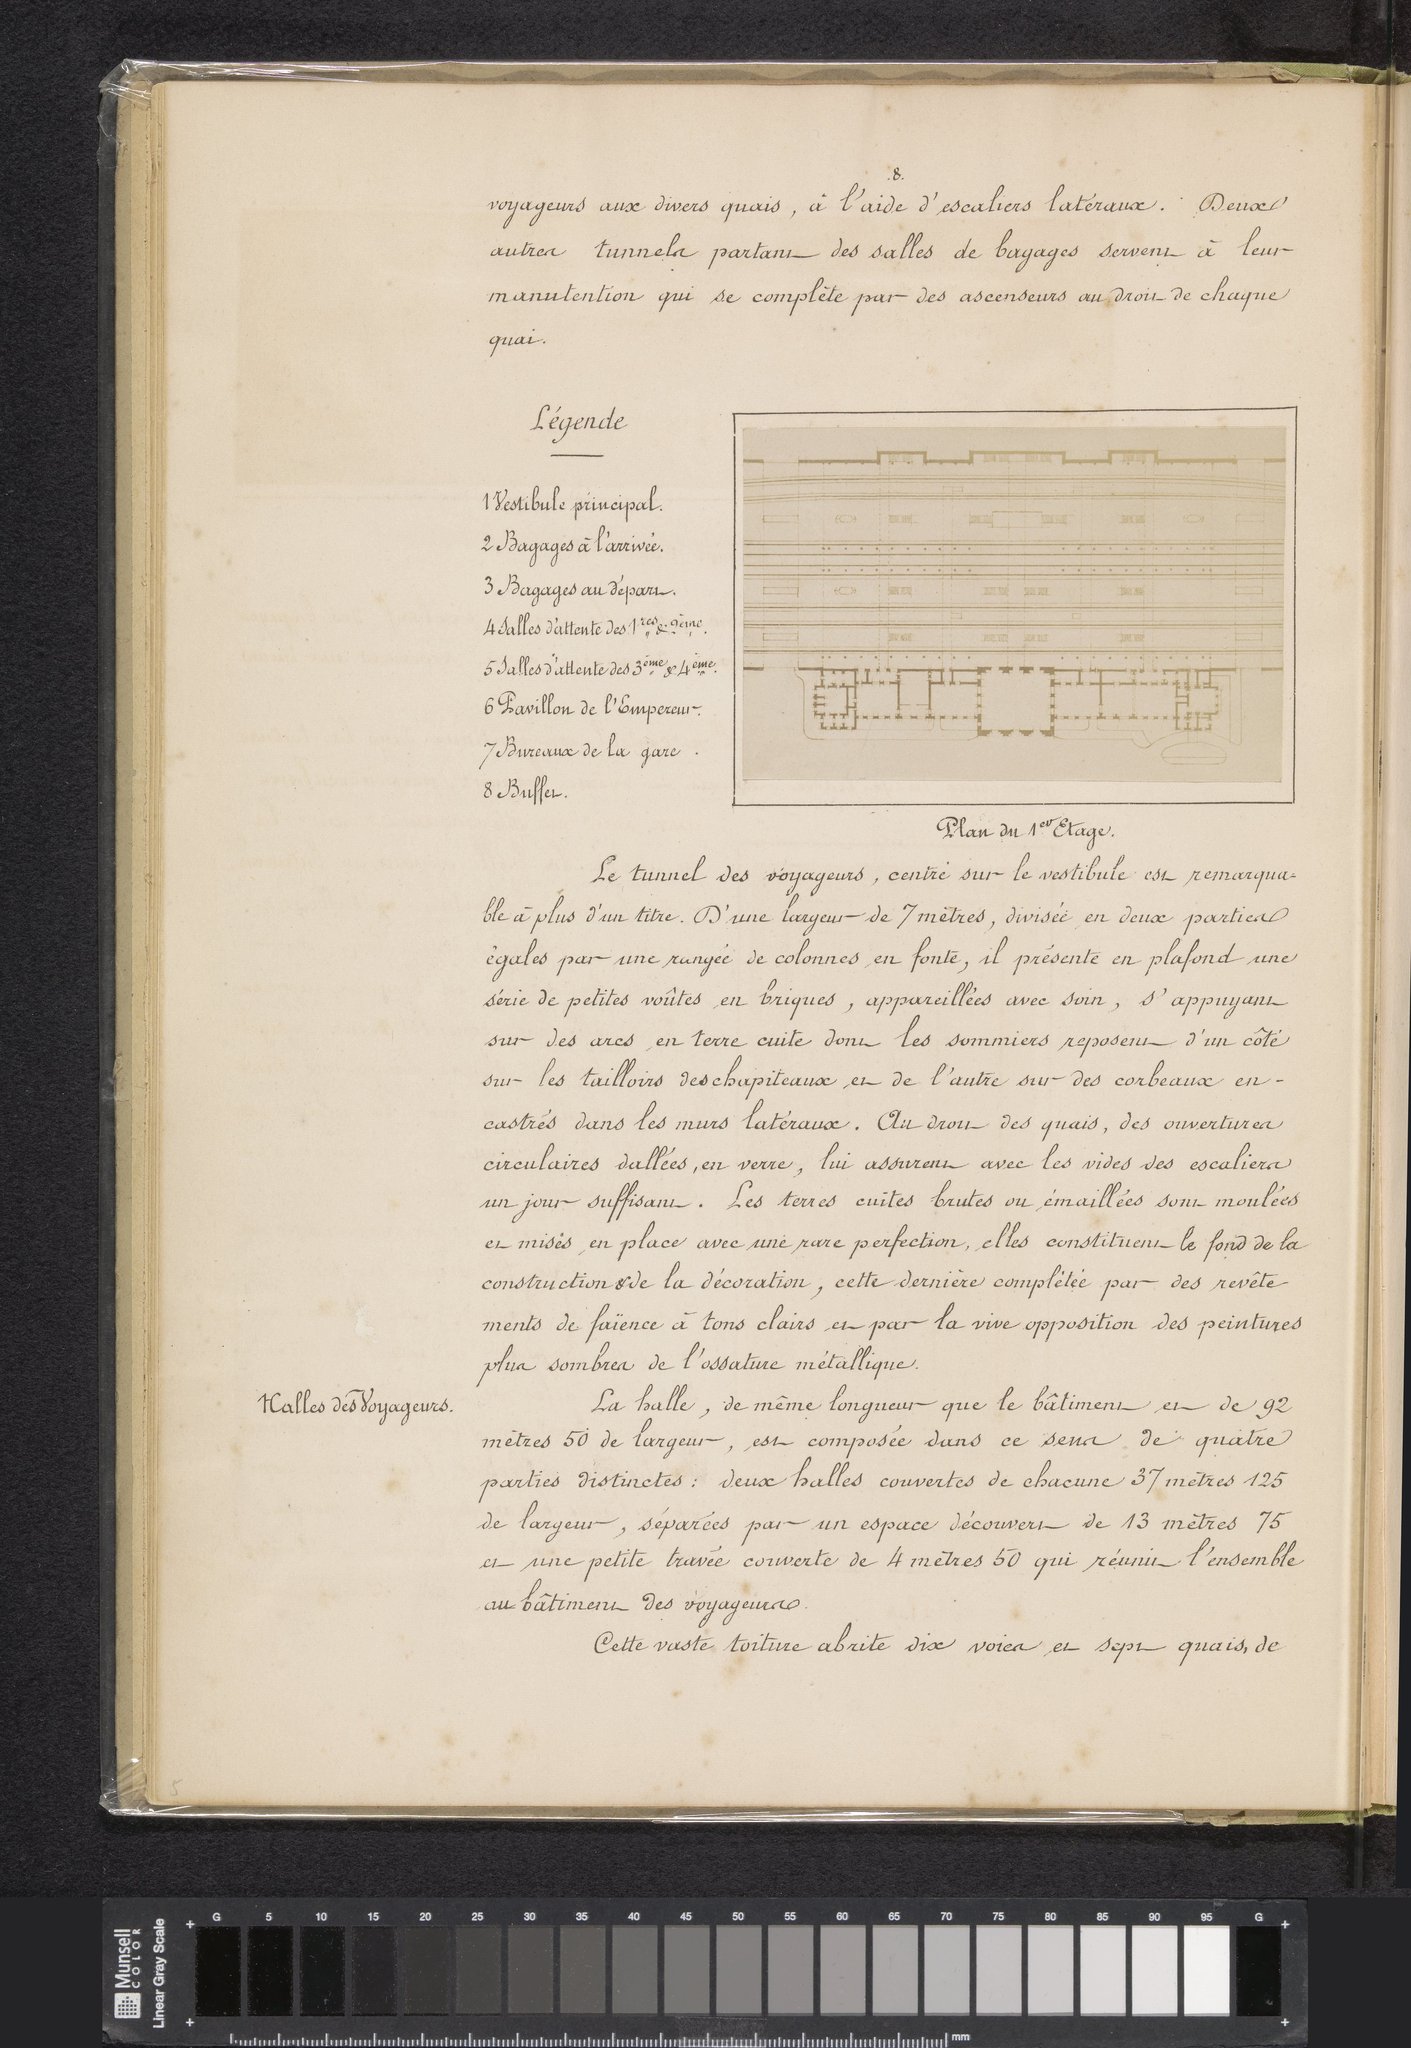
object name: reproduction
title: Fotoreproductie van een plattegrond van de eerste etage van Hannover Hauptbahnhof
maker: Anonymous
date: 1874-1884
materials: photographic support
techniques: albumen print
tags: maps, atlases, railway, train, station; shelter (railway, tramway)